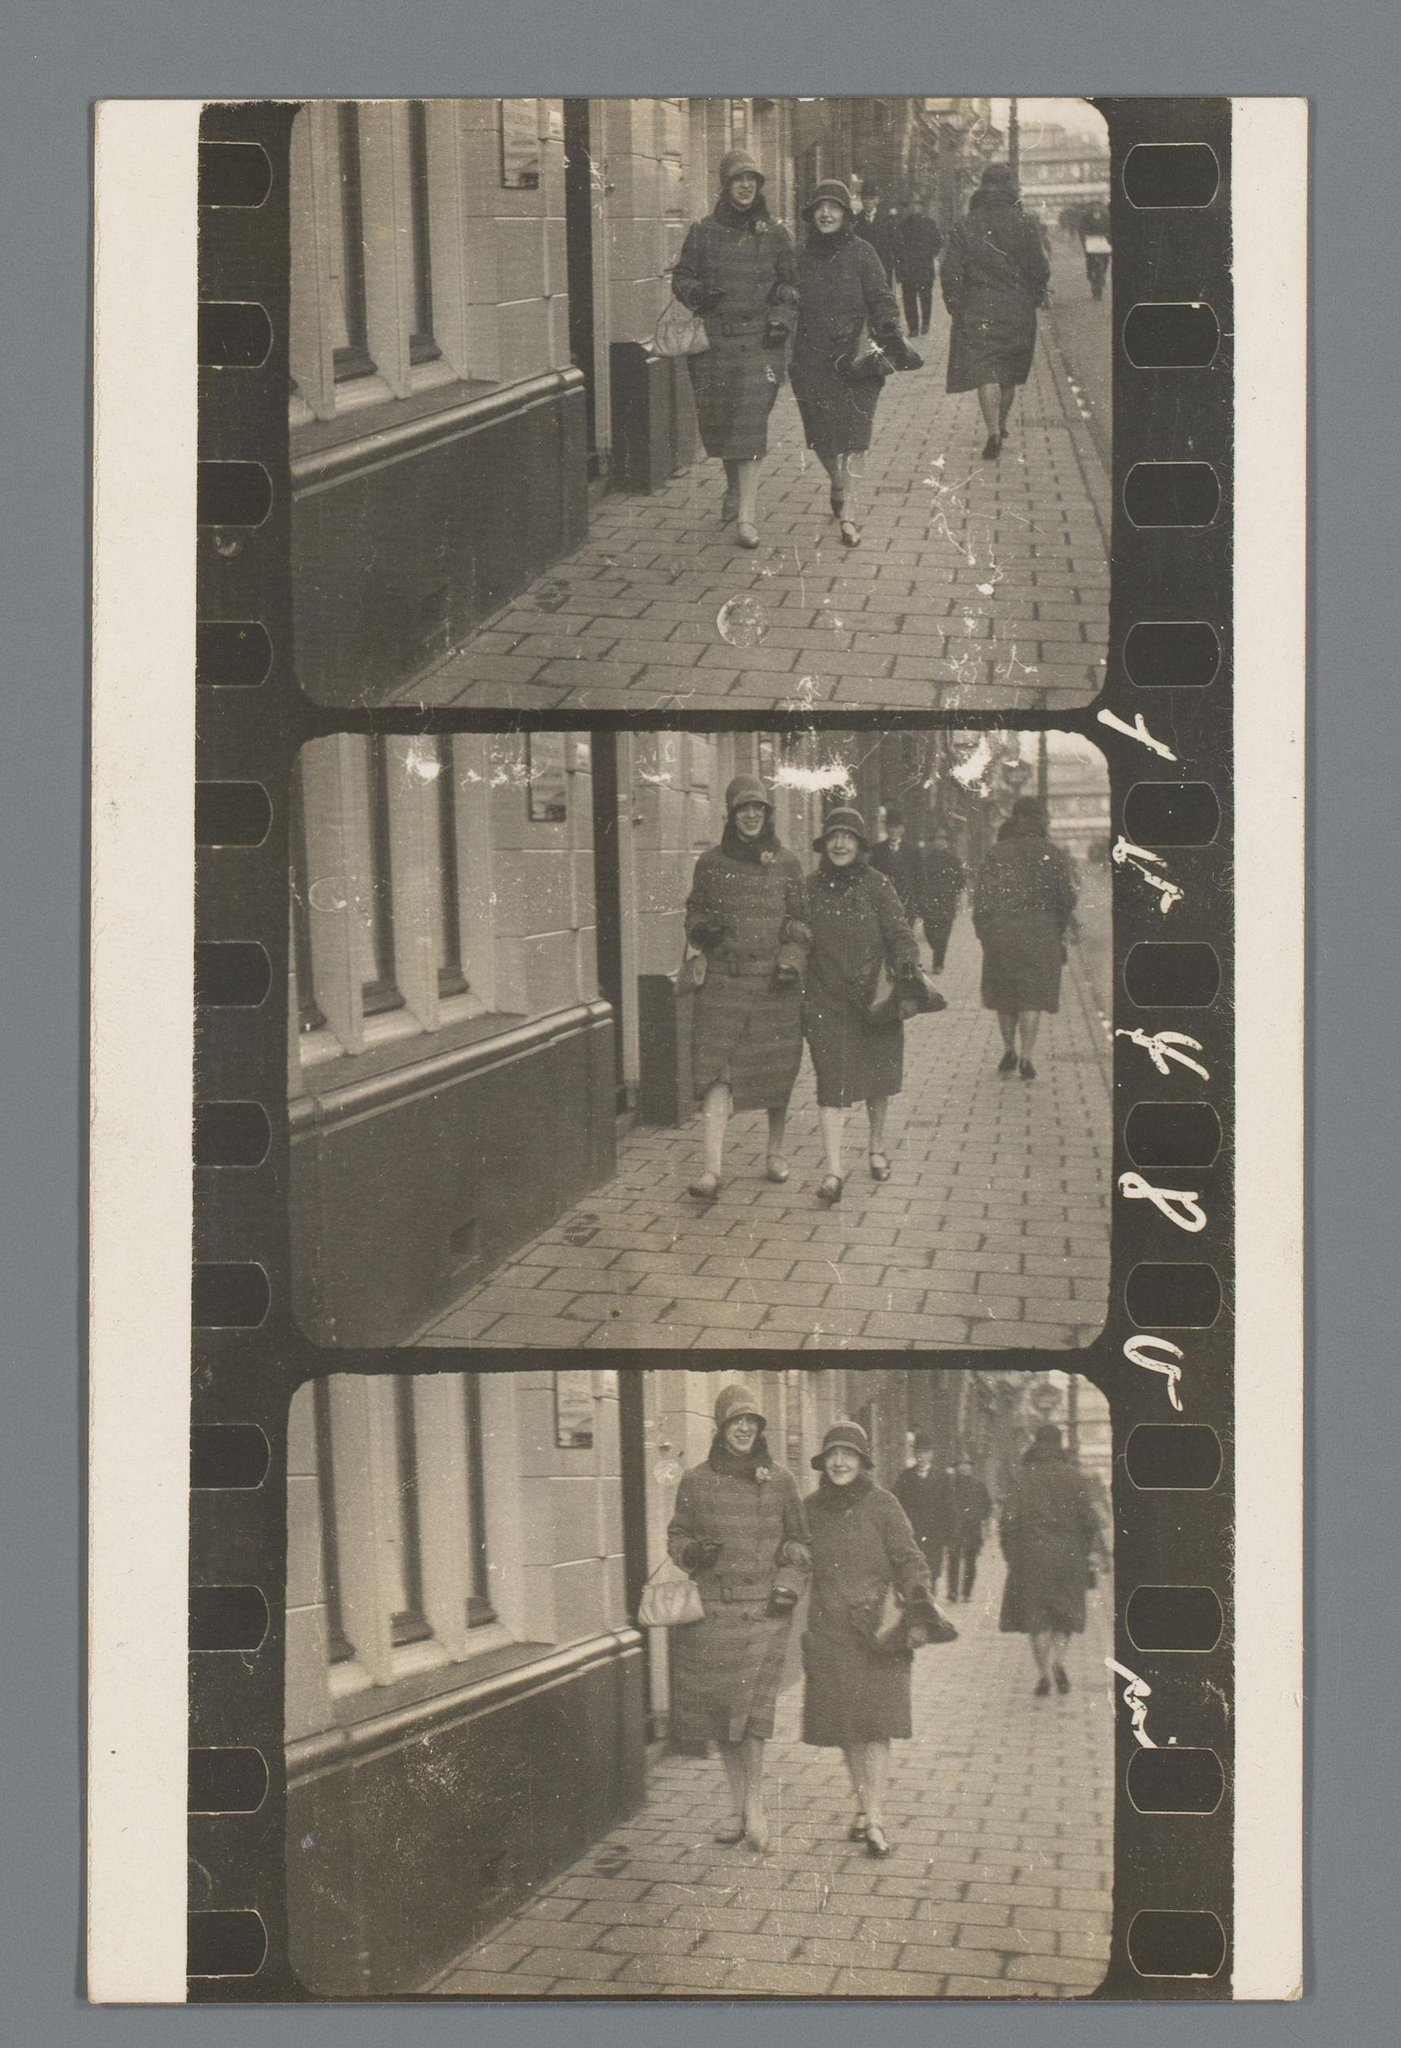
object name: photograph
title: Prentbriefkaart met drie filmbeelden van twee onbekende vrouwen op straat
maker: Anonymous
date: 1910-1940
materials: paper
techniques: gelatin silver print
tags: adult woman, street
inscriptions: inscription: ‘TM’, number: ‘10480’